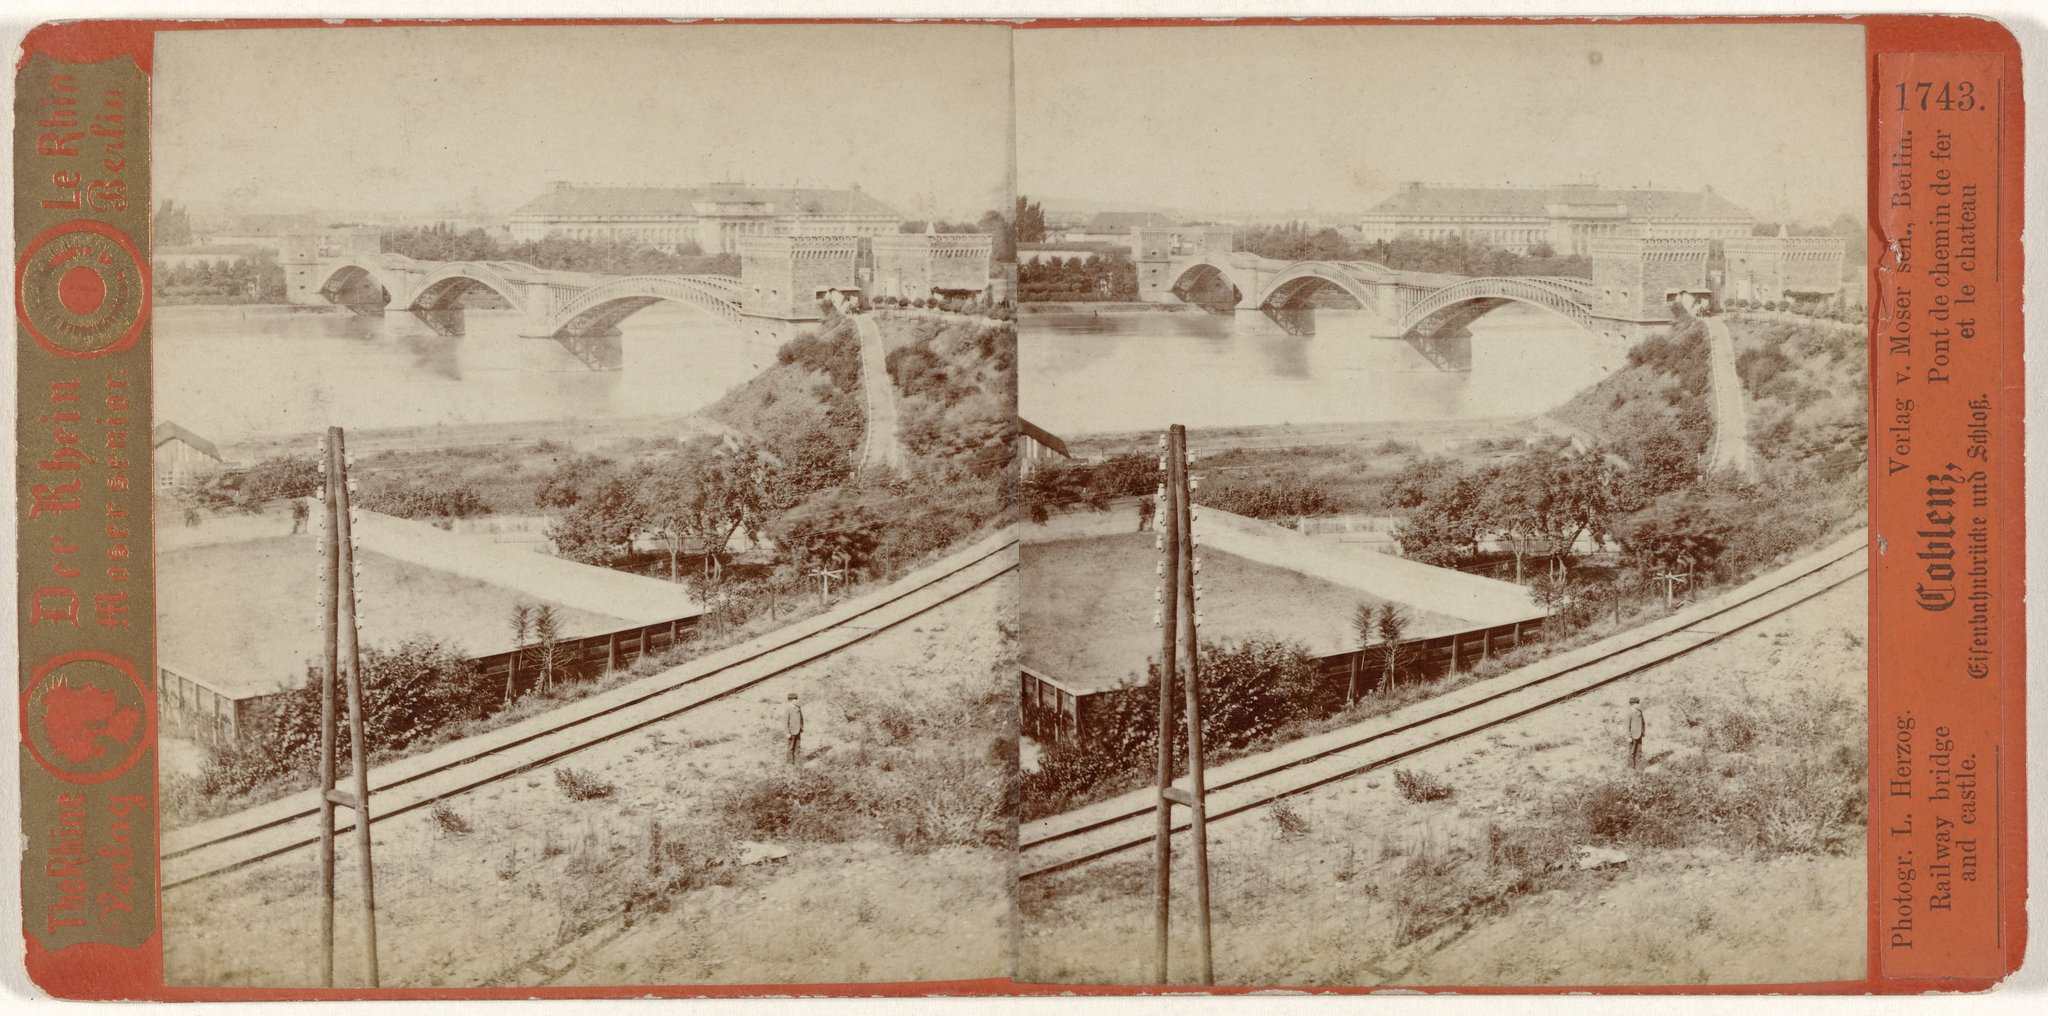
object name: stereograph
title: Der Rhein / The Rhine / Le Rhin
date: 1864-1882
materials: cardboard, paper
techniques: albumen print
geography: koblenz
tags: railway-traffic, river, landscape with bridge, viaduct or aqueduct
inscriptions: number: ‘1743.’, number: ‘60’, inscription: ‘Photographiser und Stereoscopischer/ Kunstverlag/ von/ Moser senior/ (...)/ BERLIN/ 23, Unter den Linden, 23/ (...) Glas-u. Papier-Stereoscopbildern/ aller Weltgegenden’